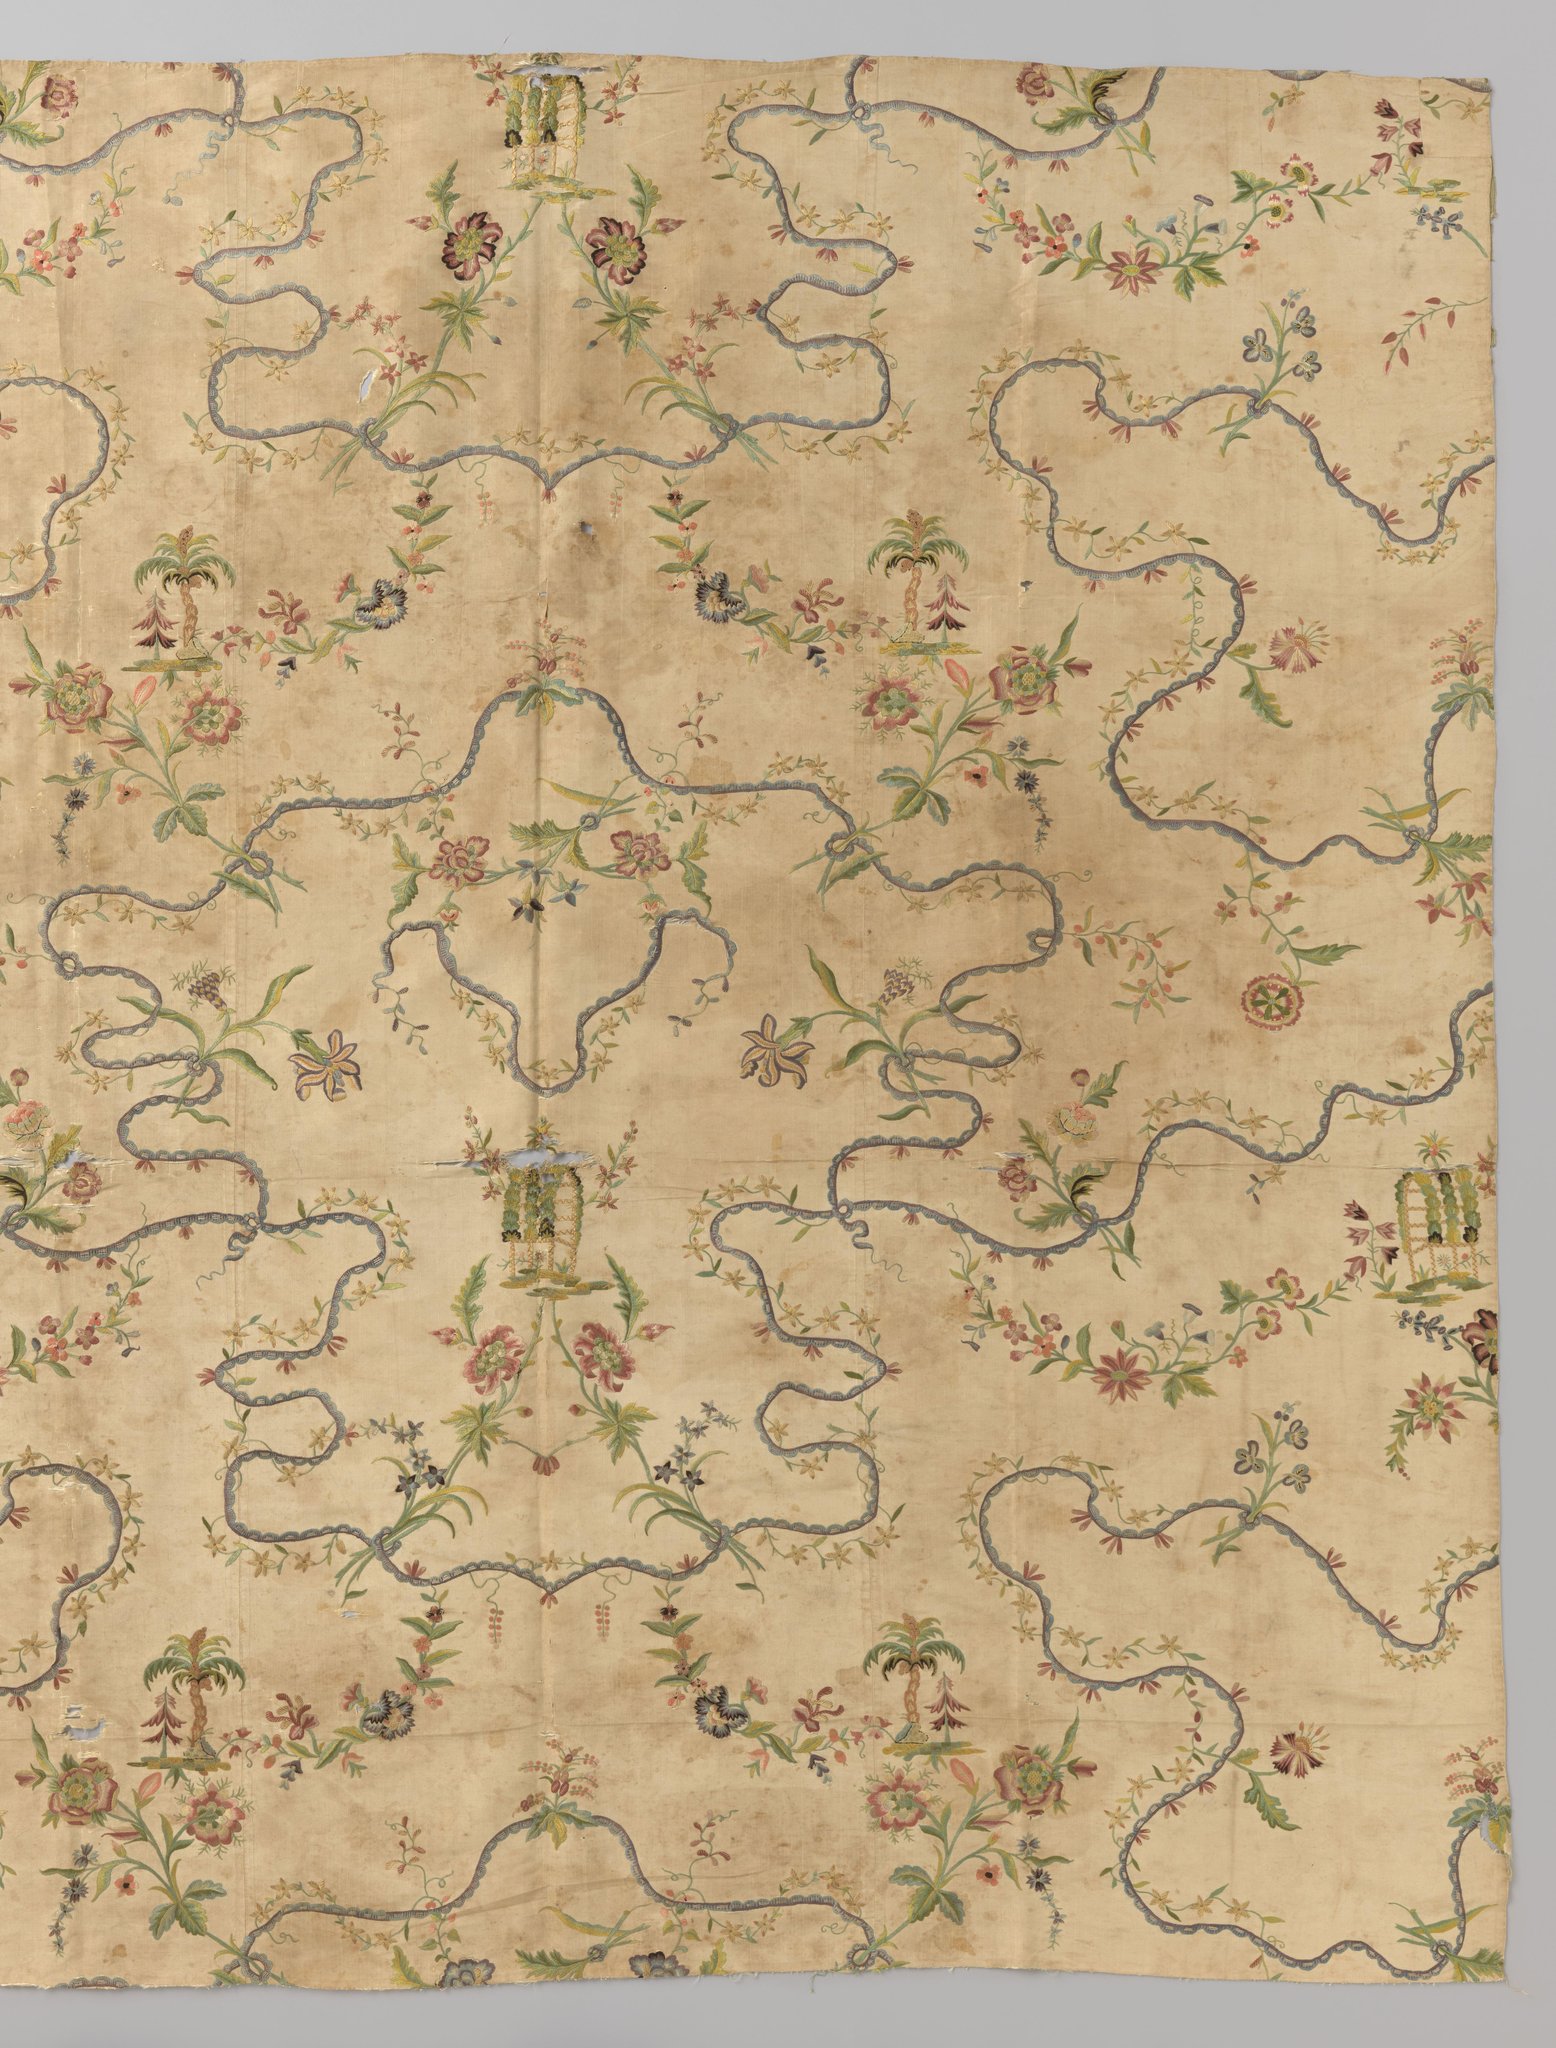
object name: fragment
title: Fragment bespanning van crème-kleurige ripszijde met kleurig borduurwerk met grillig slingerende linten met o.a. palmbomen en loofhutten(?), takken en ranken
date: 1740-1760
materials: silk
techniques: embroidered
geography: france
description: Fragment bespanning van crème-kleurige ripszijde met kleurig borduursel van symmetrisch-breed en grillig slingerende, geschulpte linten van half lichtblauw, half paars. Op grote afstanden staan afwisselend een palmboom en een begroeide pergola (loofhutten?). Losse takken met genuanceerd gekleurde bloemen worden in een lus van de linten gebonden, terwijl dunnere ranken met fijne bloemen zich om de linten slingeren.